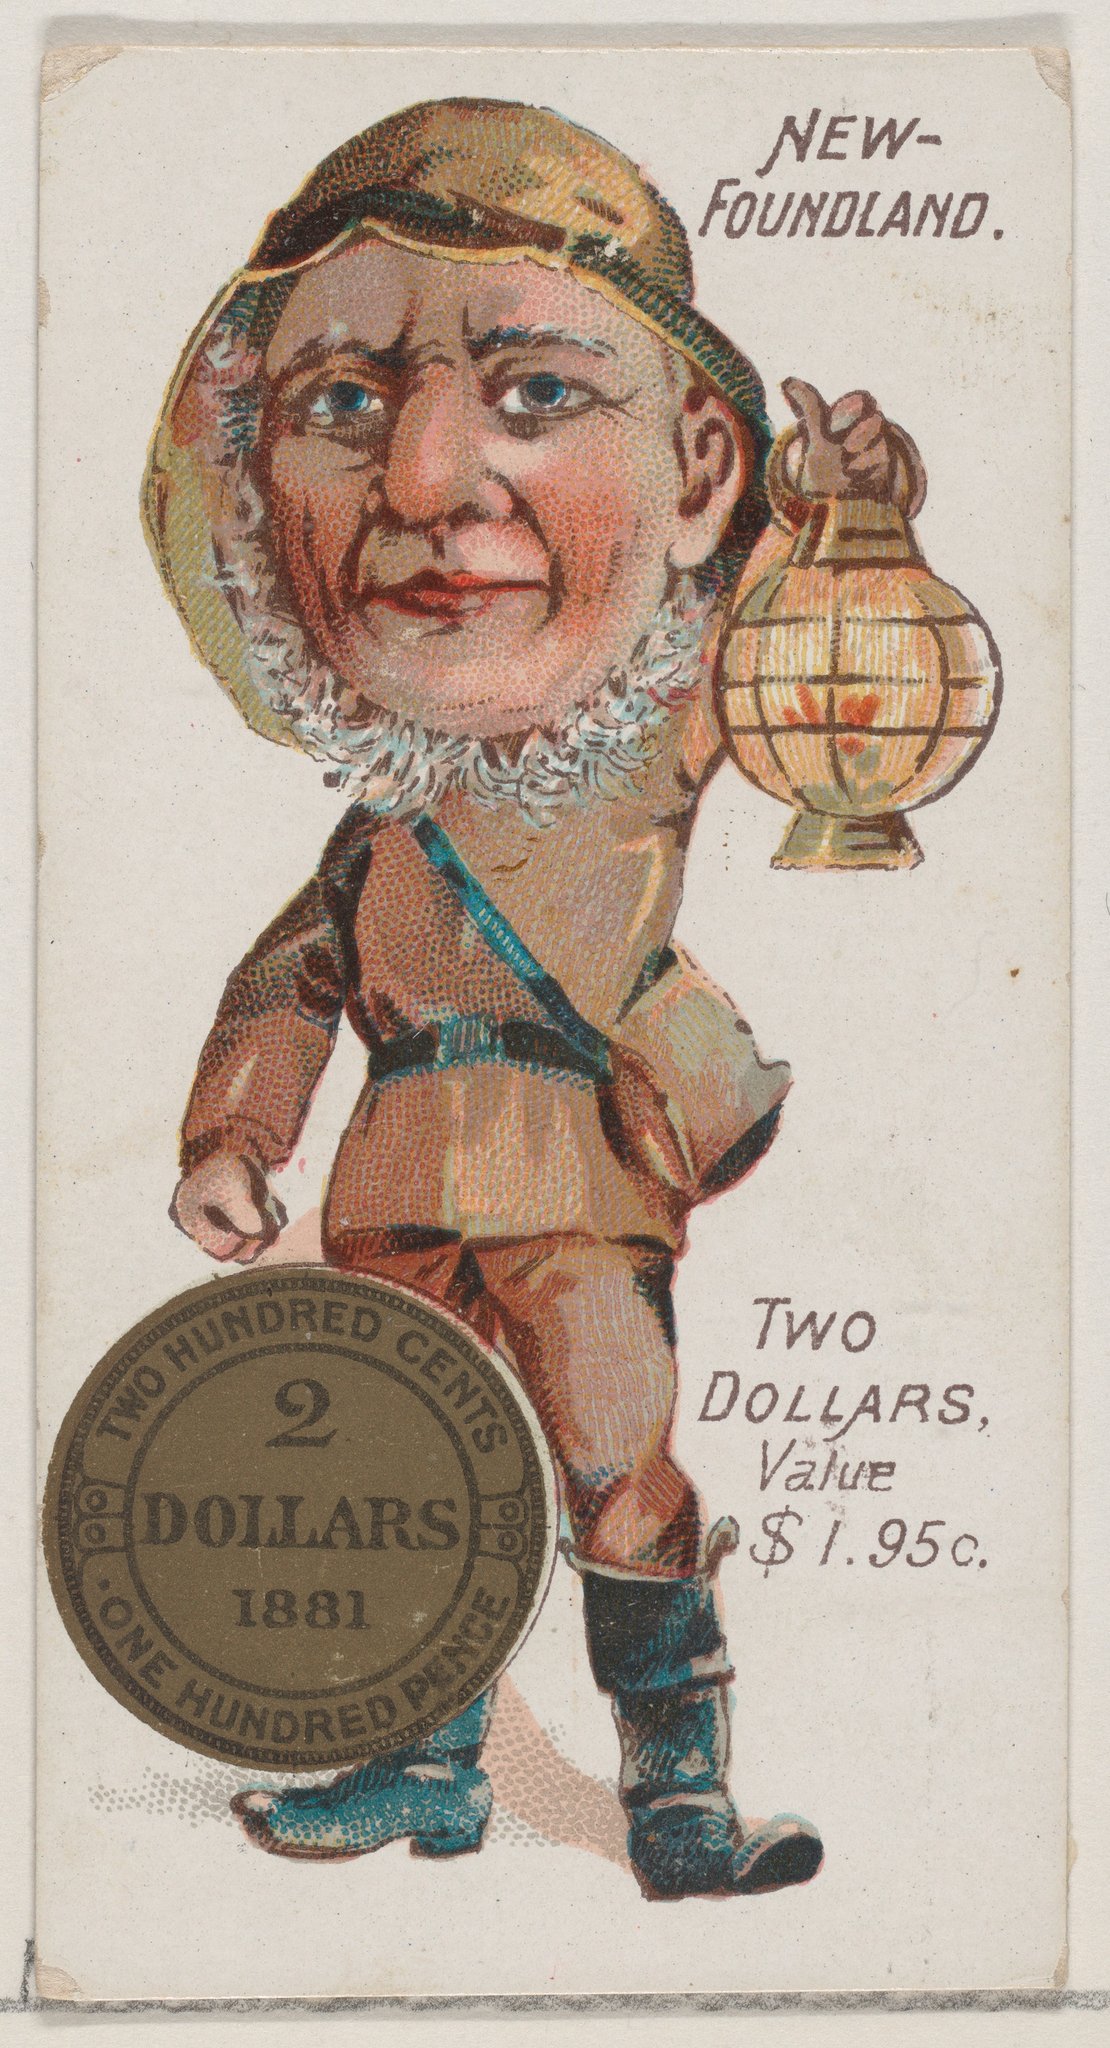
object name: print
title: Newfoundland, Two Dollars, from the series Coins of All Nations (N72, variation 1) for Duke brand cigarettes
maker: w. duke, sons & co.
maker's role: publisher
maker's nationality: american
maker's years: 1870-1920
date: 1889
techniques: color lithograph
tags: men,coins